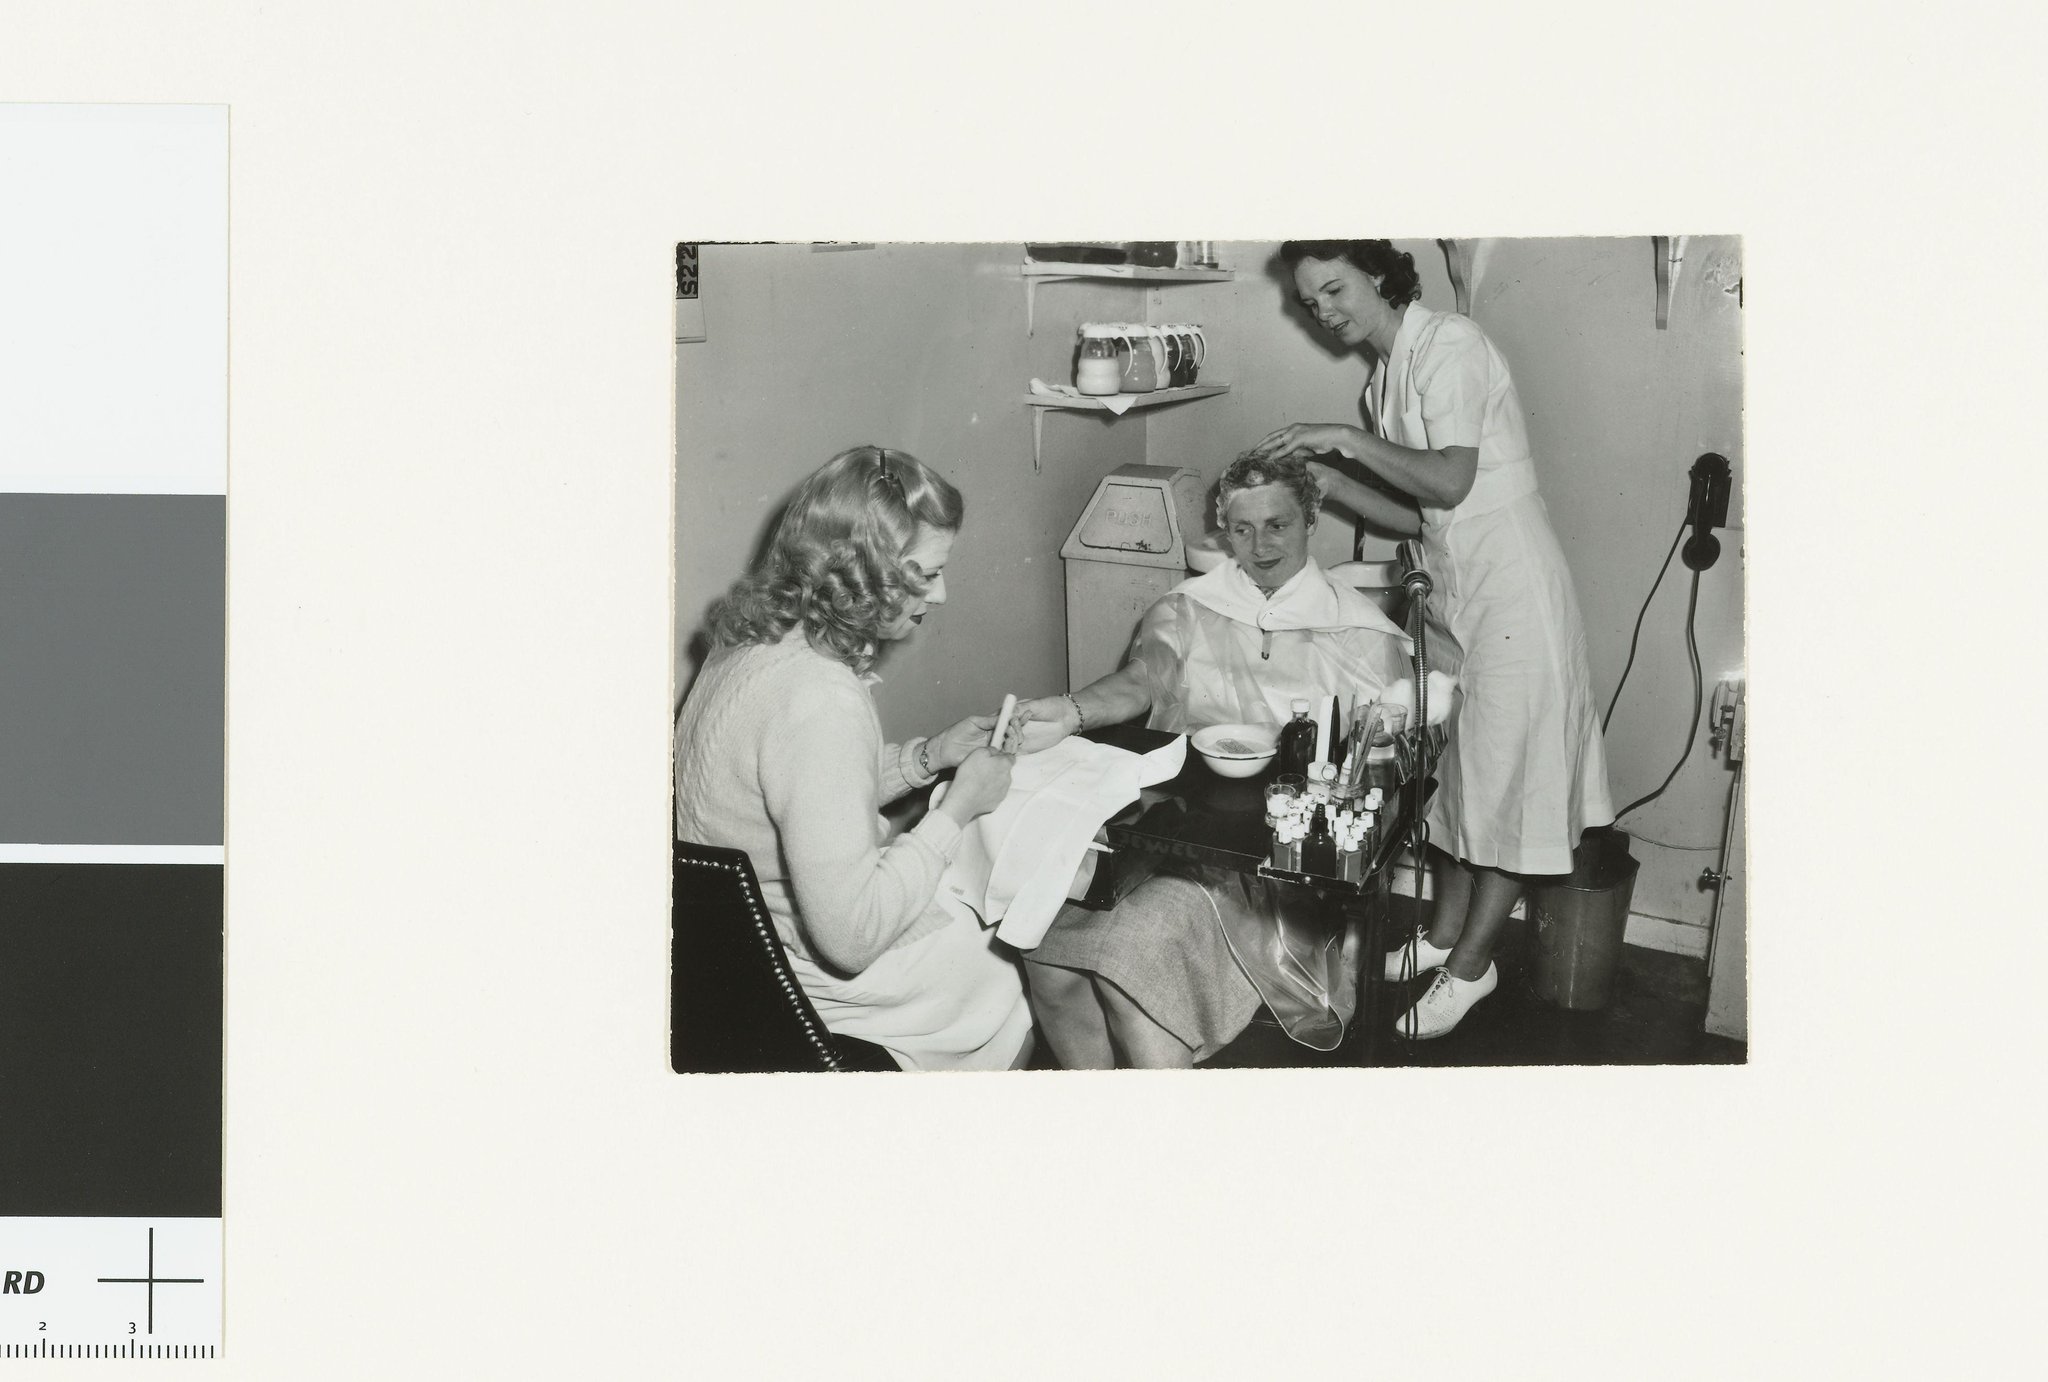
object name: documentary photograph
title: Fanny krijgt hoofdmassage en laat haar nagels lakken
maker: Anonymous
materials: photographic support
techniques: photography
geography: hollywood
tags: ons vrije nederland, baarn, hoofddorp, atleet, fanny blankers-koen, hollywood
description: Fanny Blankers-Koen ondergaat een schoonheidsbehandeling in 'House of Westmore', een schoonheidssalon in Hollywood. Fanny krijgt een hoofdmassage en ondertussen worden haar nagels gevijld. De serie 'Fanny in Amerika' bevat zes foto's.